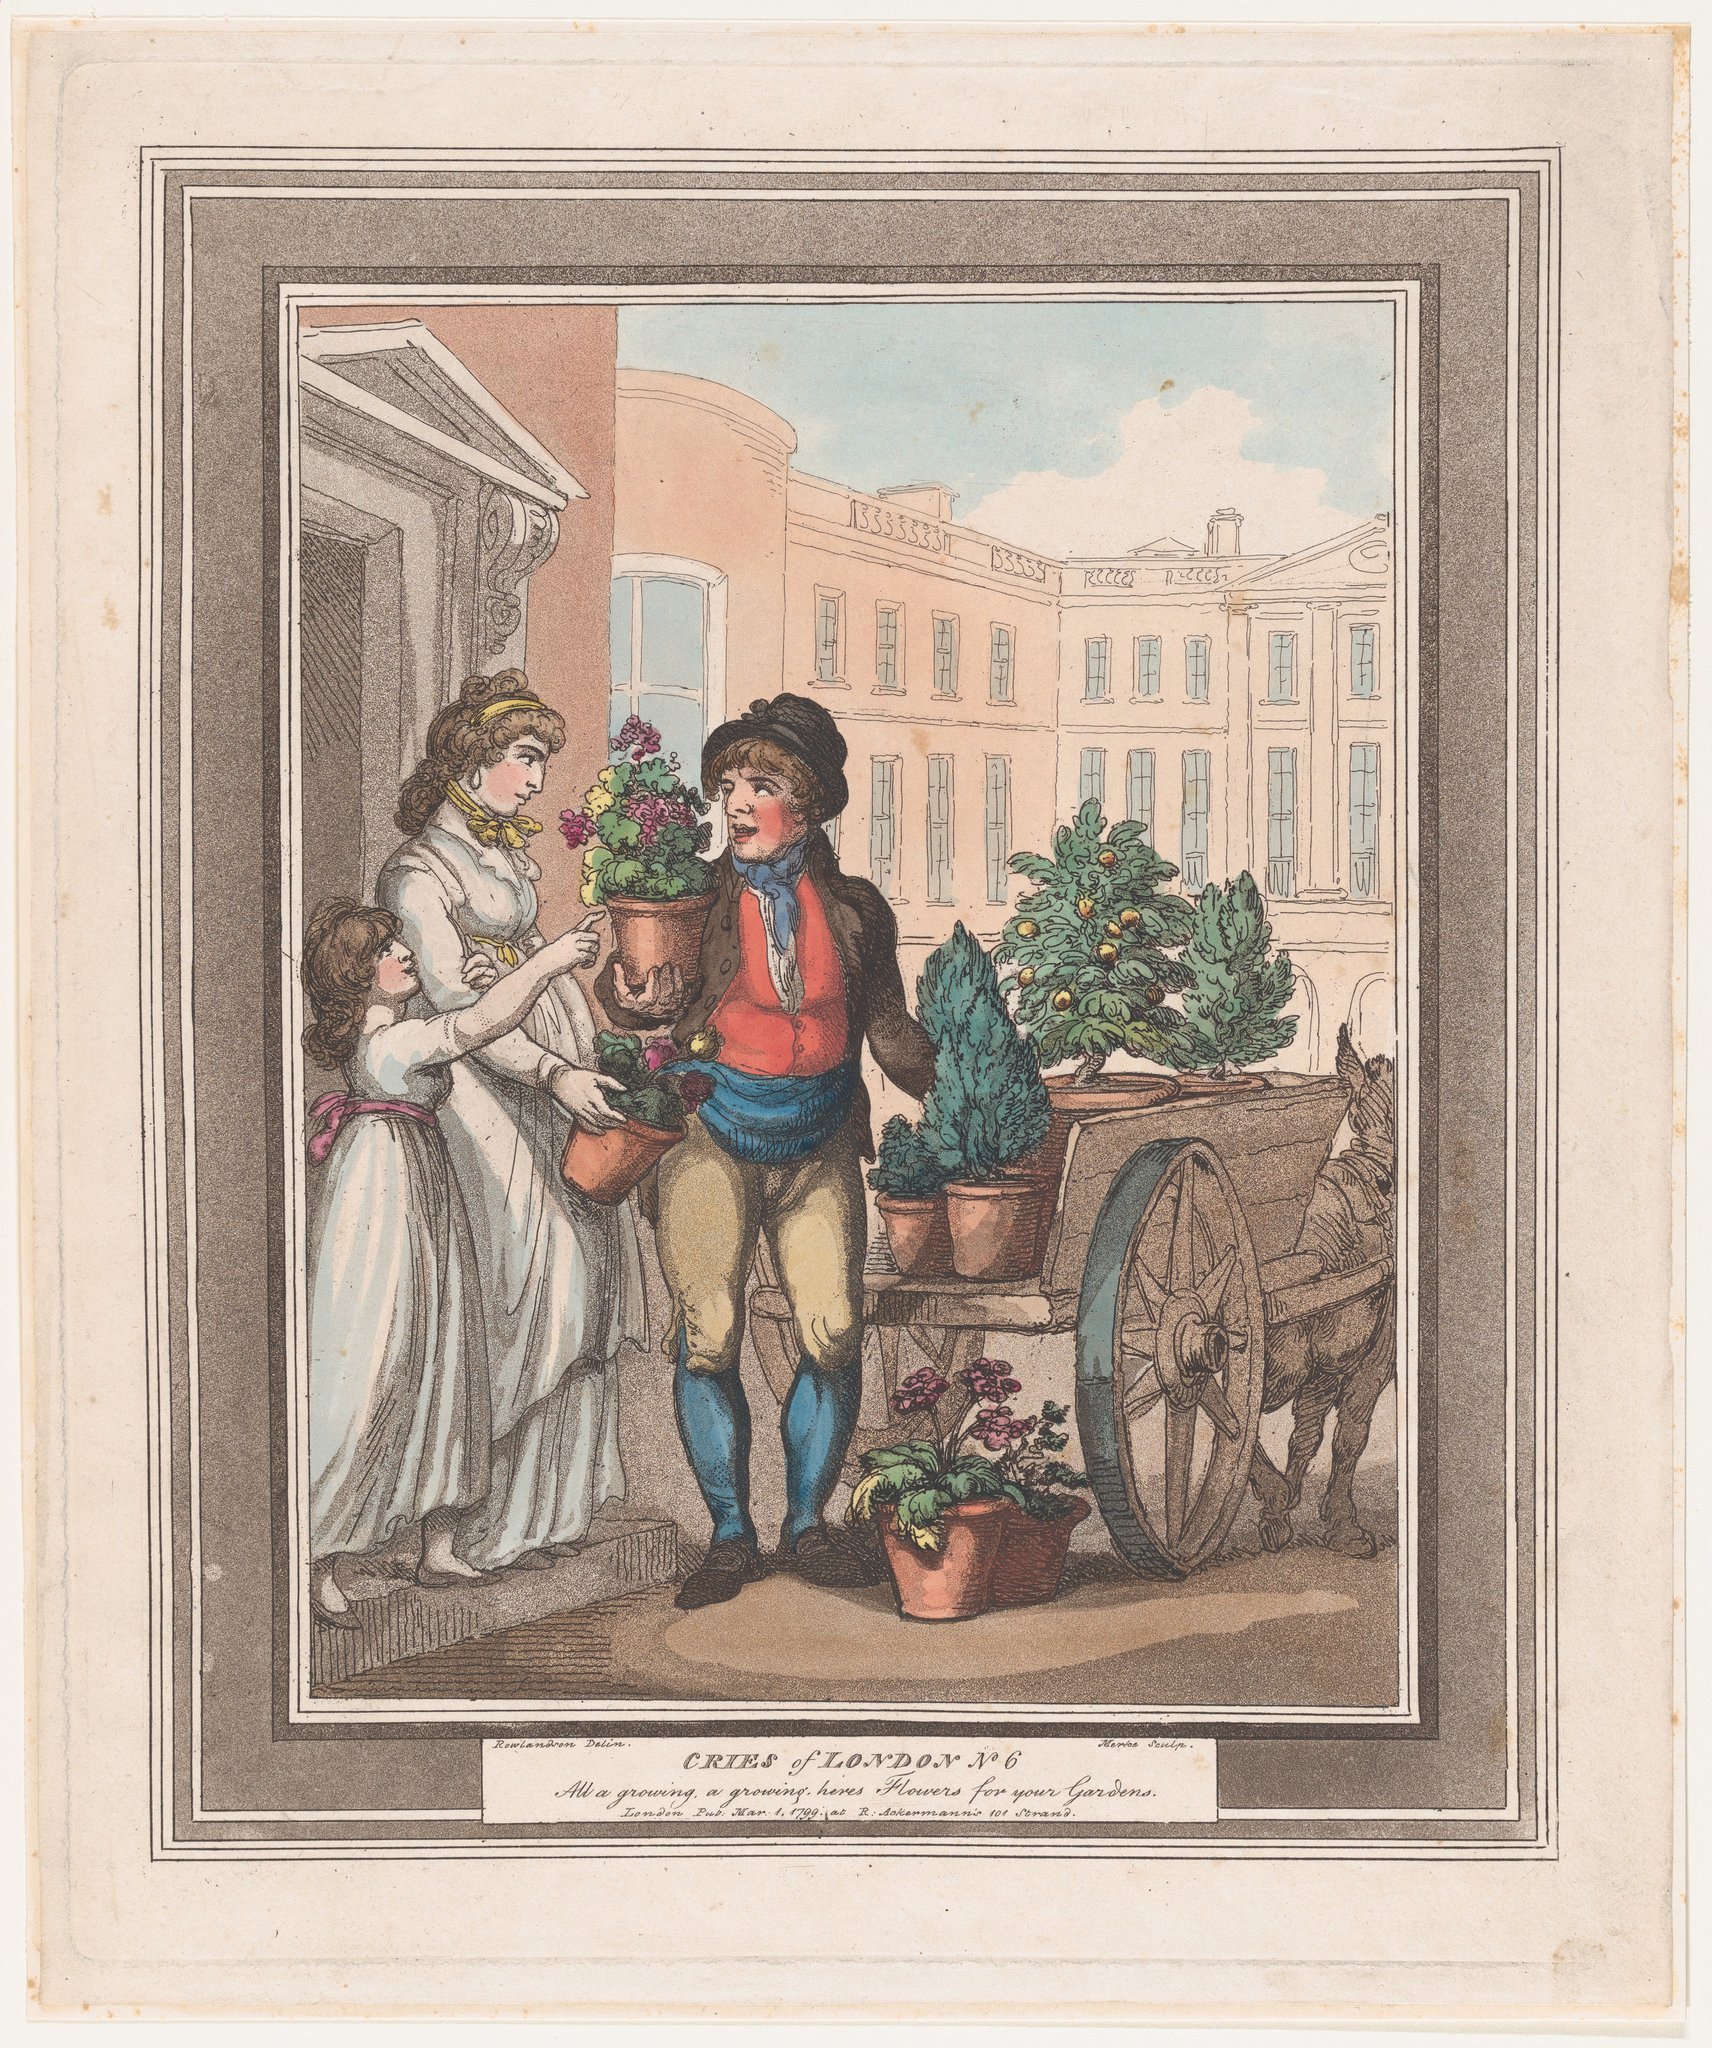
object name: print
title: Cries of London, No. 6: All a growing, here's Flowers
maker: henri merke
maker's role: artist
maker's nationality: swiss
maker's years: 1760-1820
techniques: aquatint, etching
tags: girls,men,women,flowers